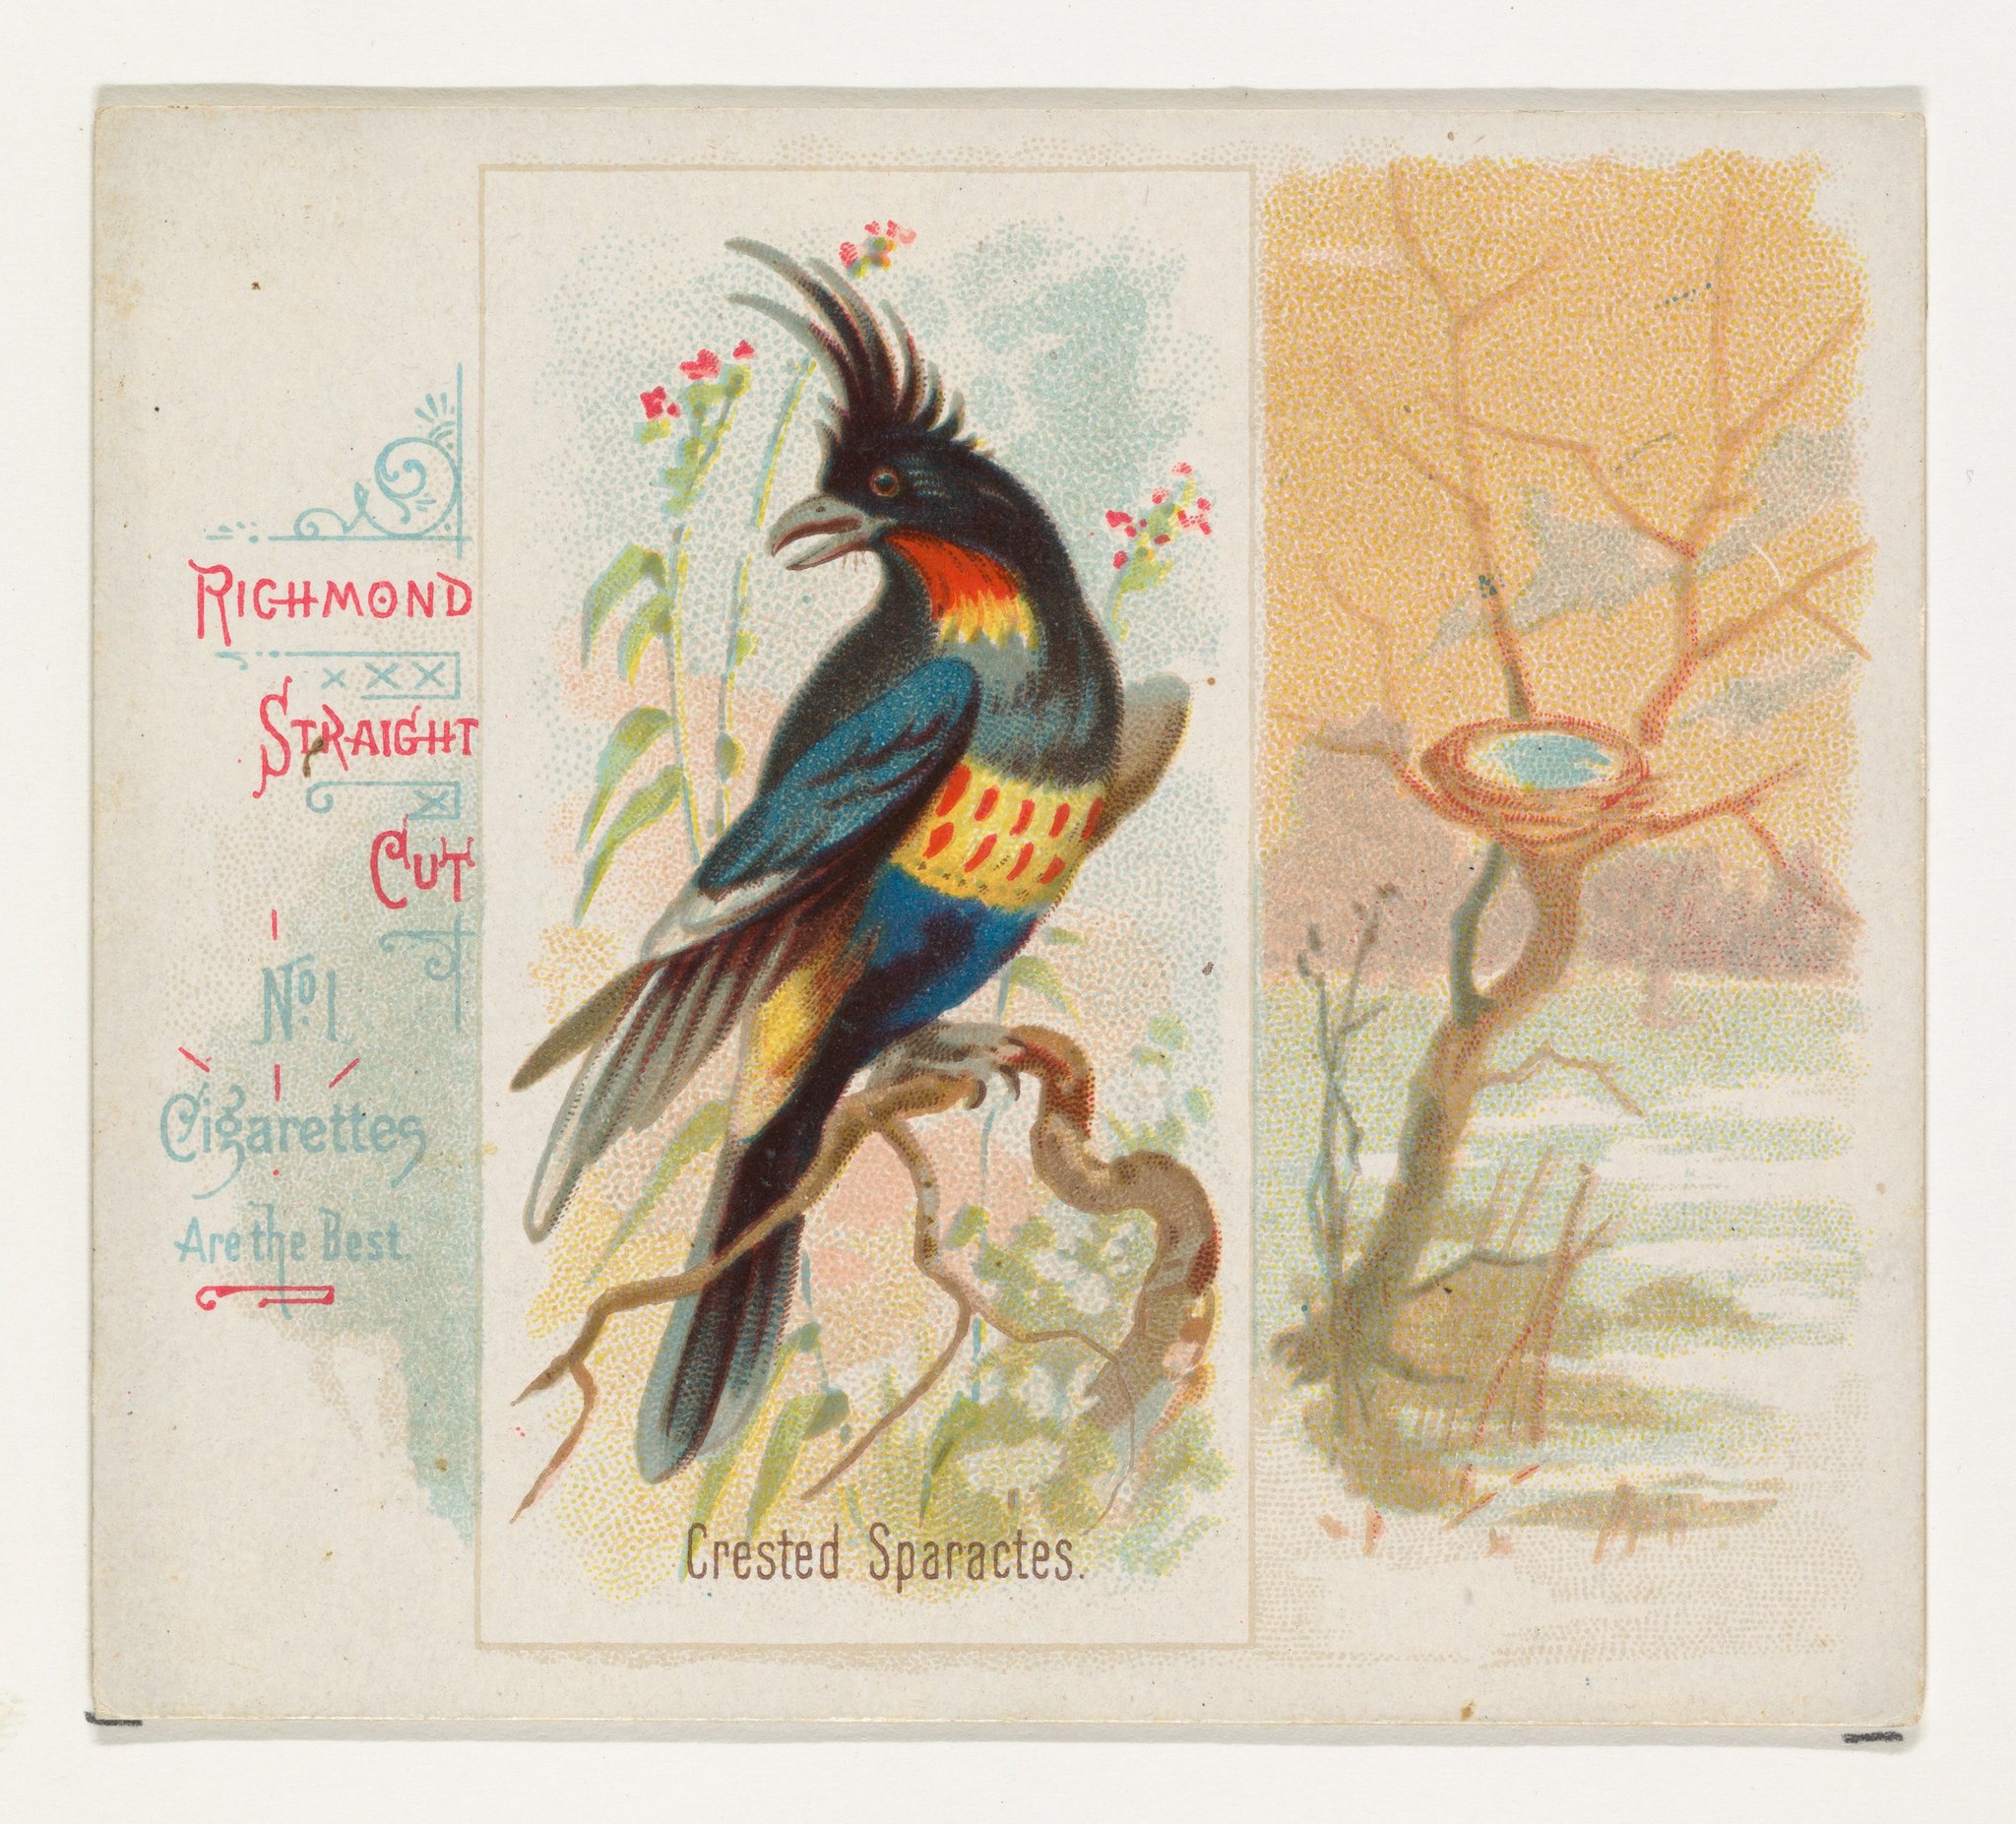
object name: print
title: Crested Sparactes, from the Song Birds of the World series (N42) for Allen & Ginter Cigarettes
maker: allen & ginter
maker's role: publisher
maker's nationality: american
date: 1890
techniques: color lithograph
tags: birds